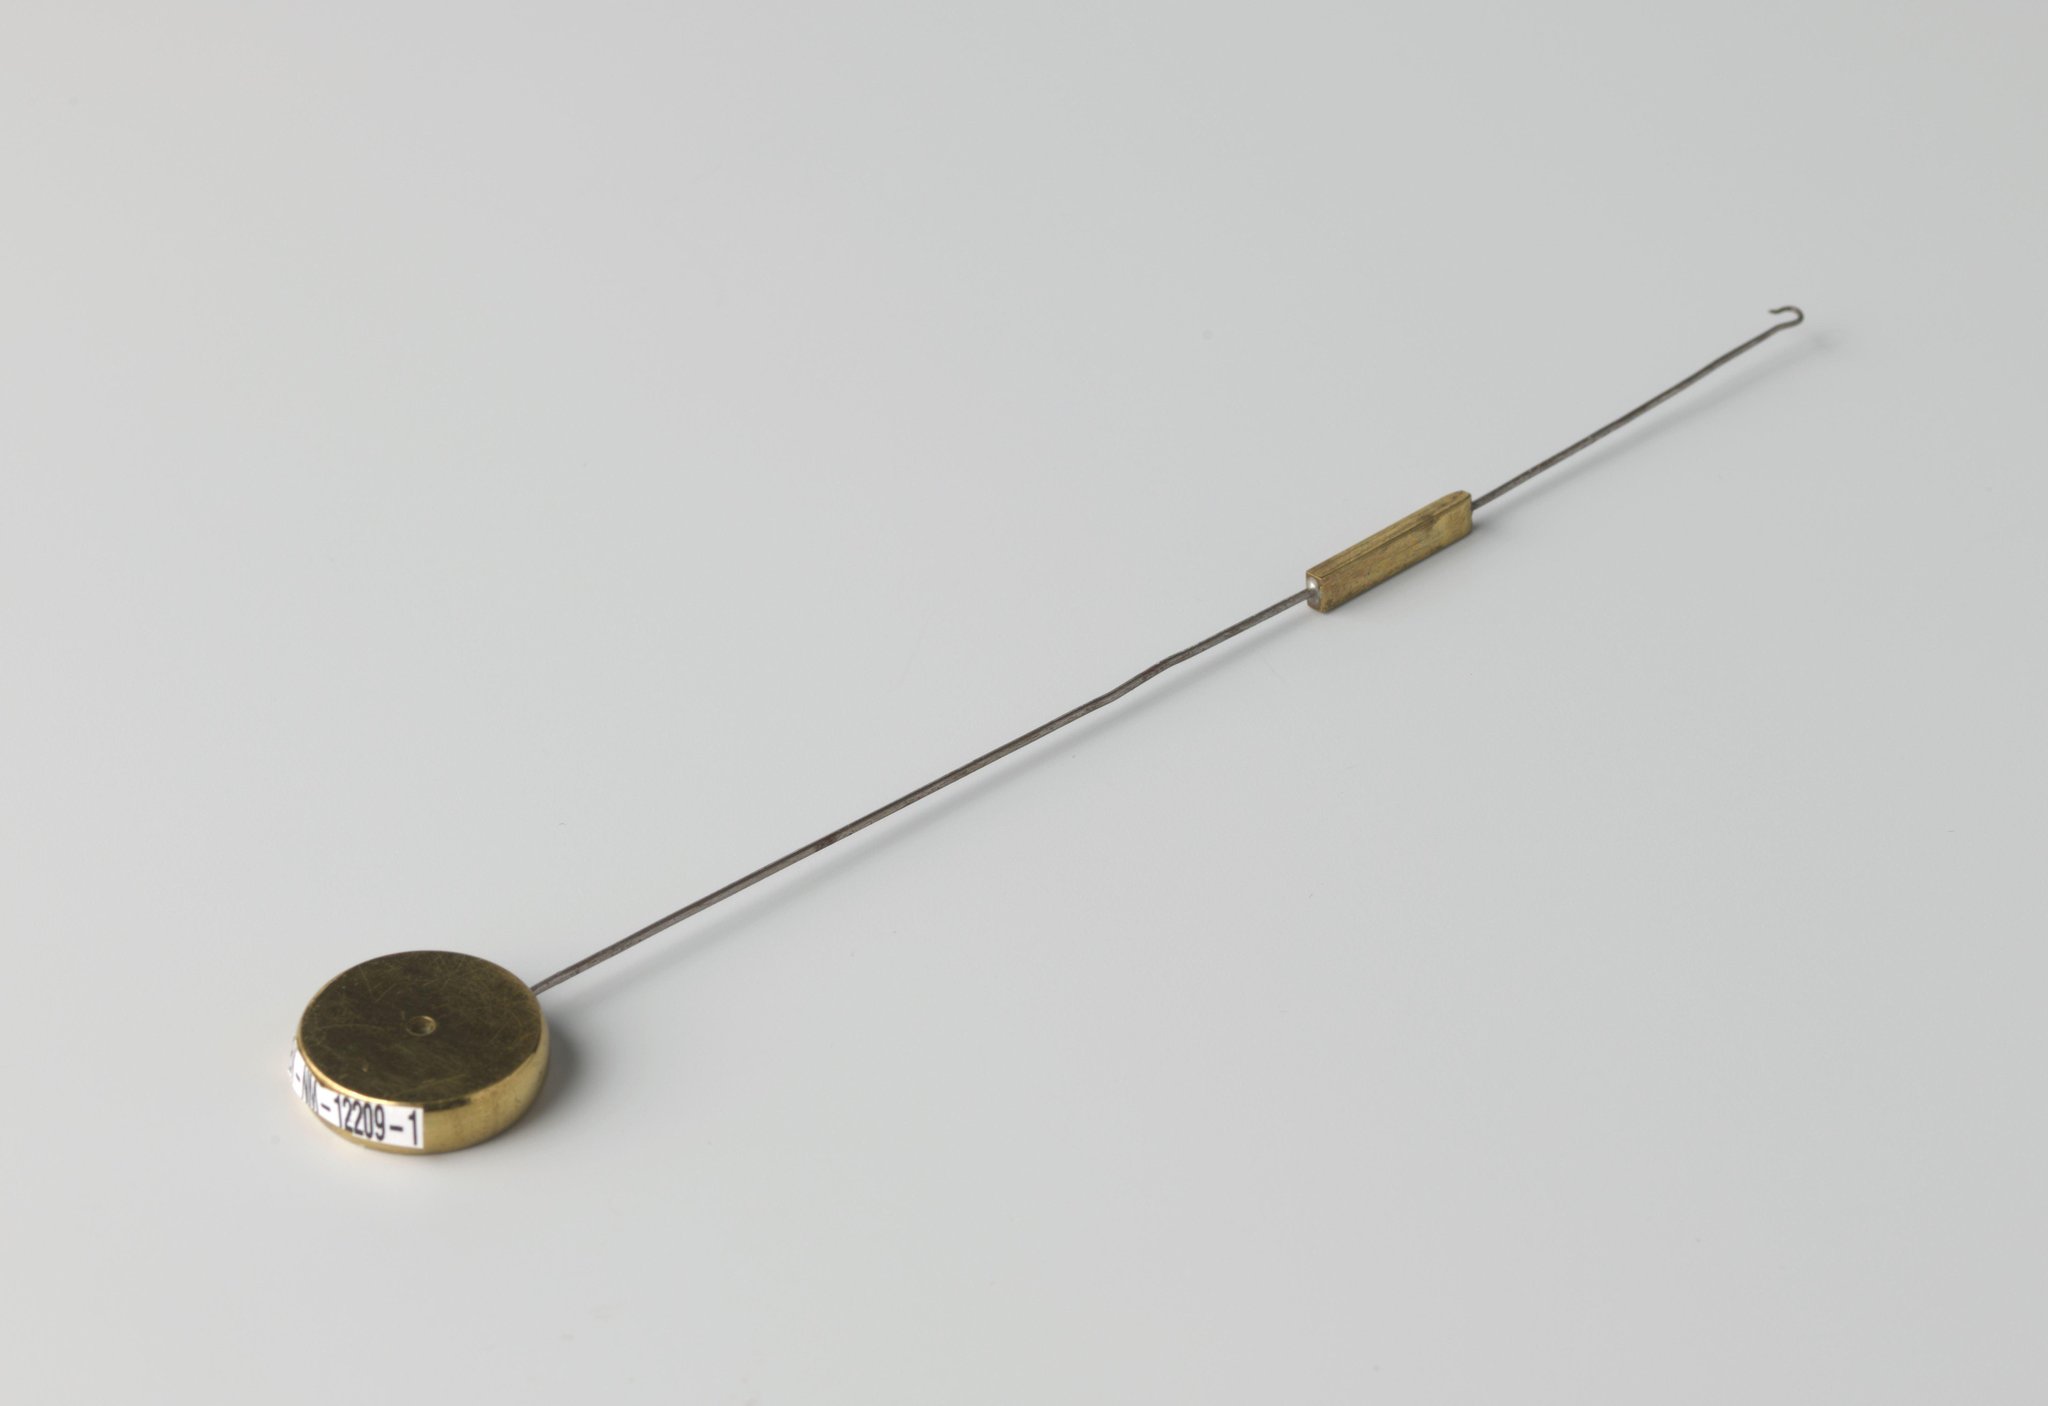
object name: sling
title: Slinger van planetariumklok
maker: f. ducommun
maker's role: clockmaker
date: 1820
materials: steel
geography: la chaux-de-fonds